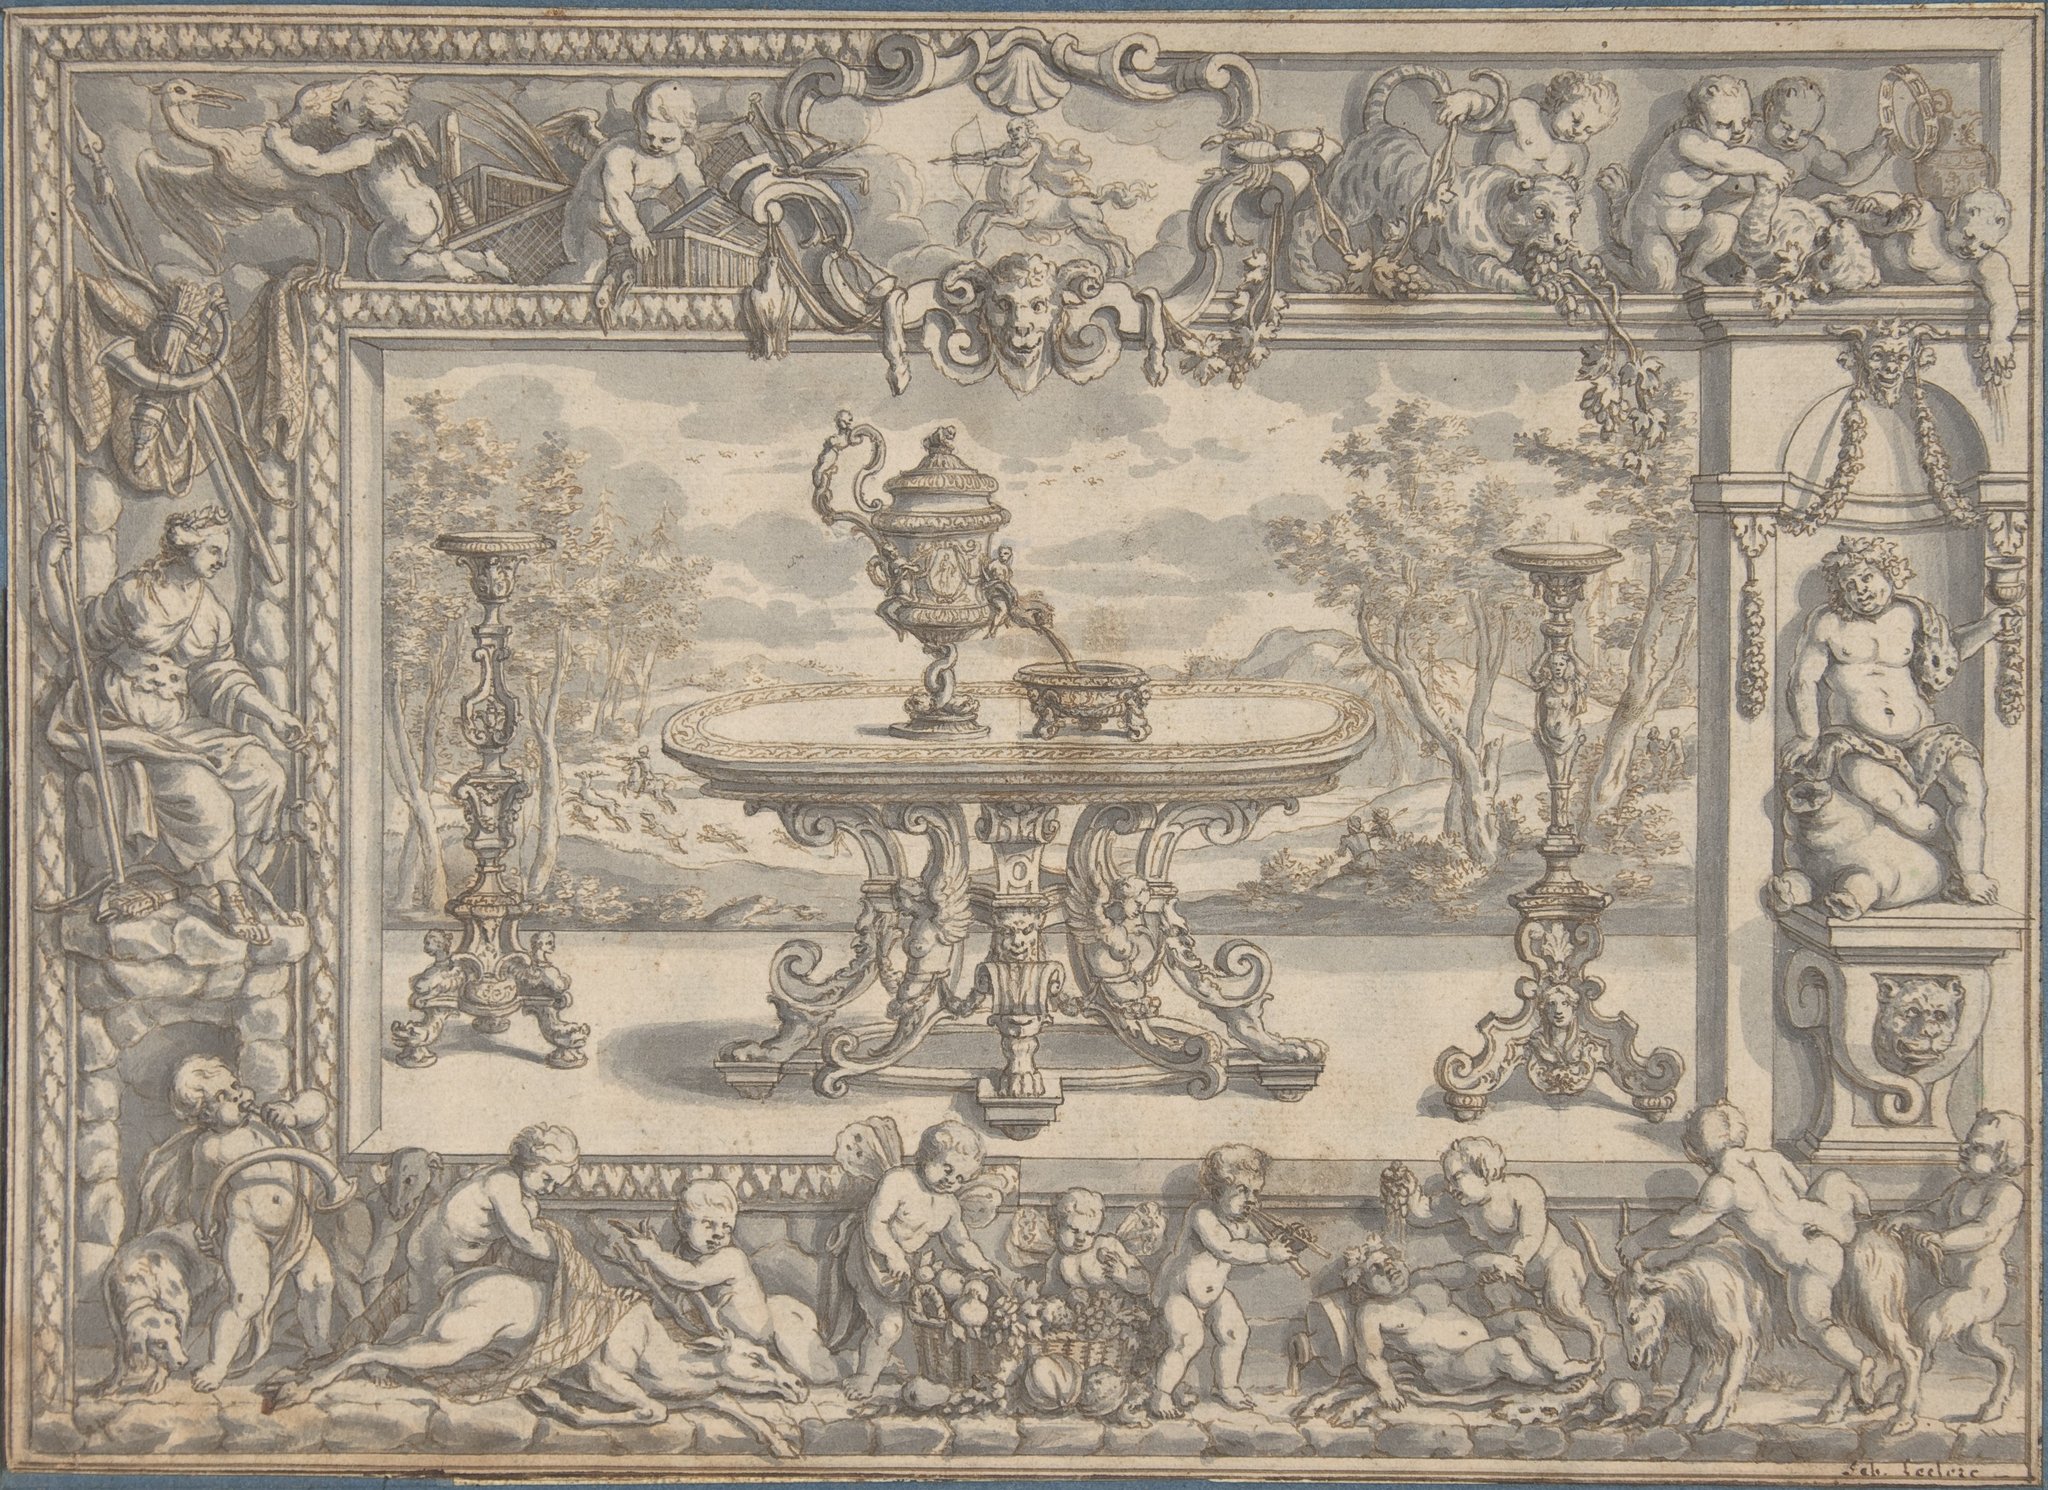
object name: drawing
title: Design for an Ewer, table and candelabra within an ornamental frame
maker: abraham drentwett the elder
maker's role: artist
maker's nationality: german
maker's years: 1647-1727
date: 1660-1727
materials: ink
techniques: brush, incising, pen, transfer, wash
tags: birds,putti,dogs,goats,tigers,ewers,tables